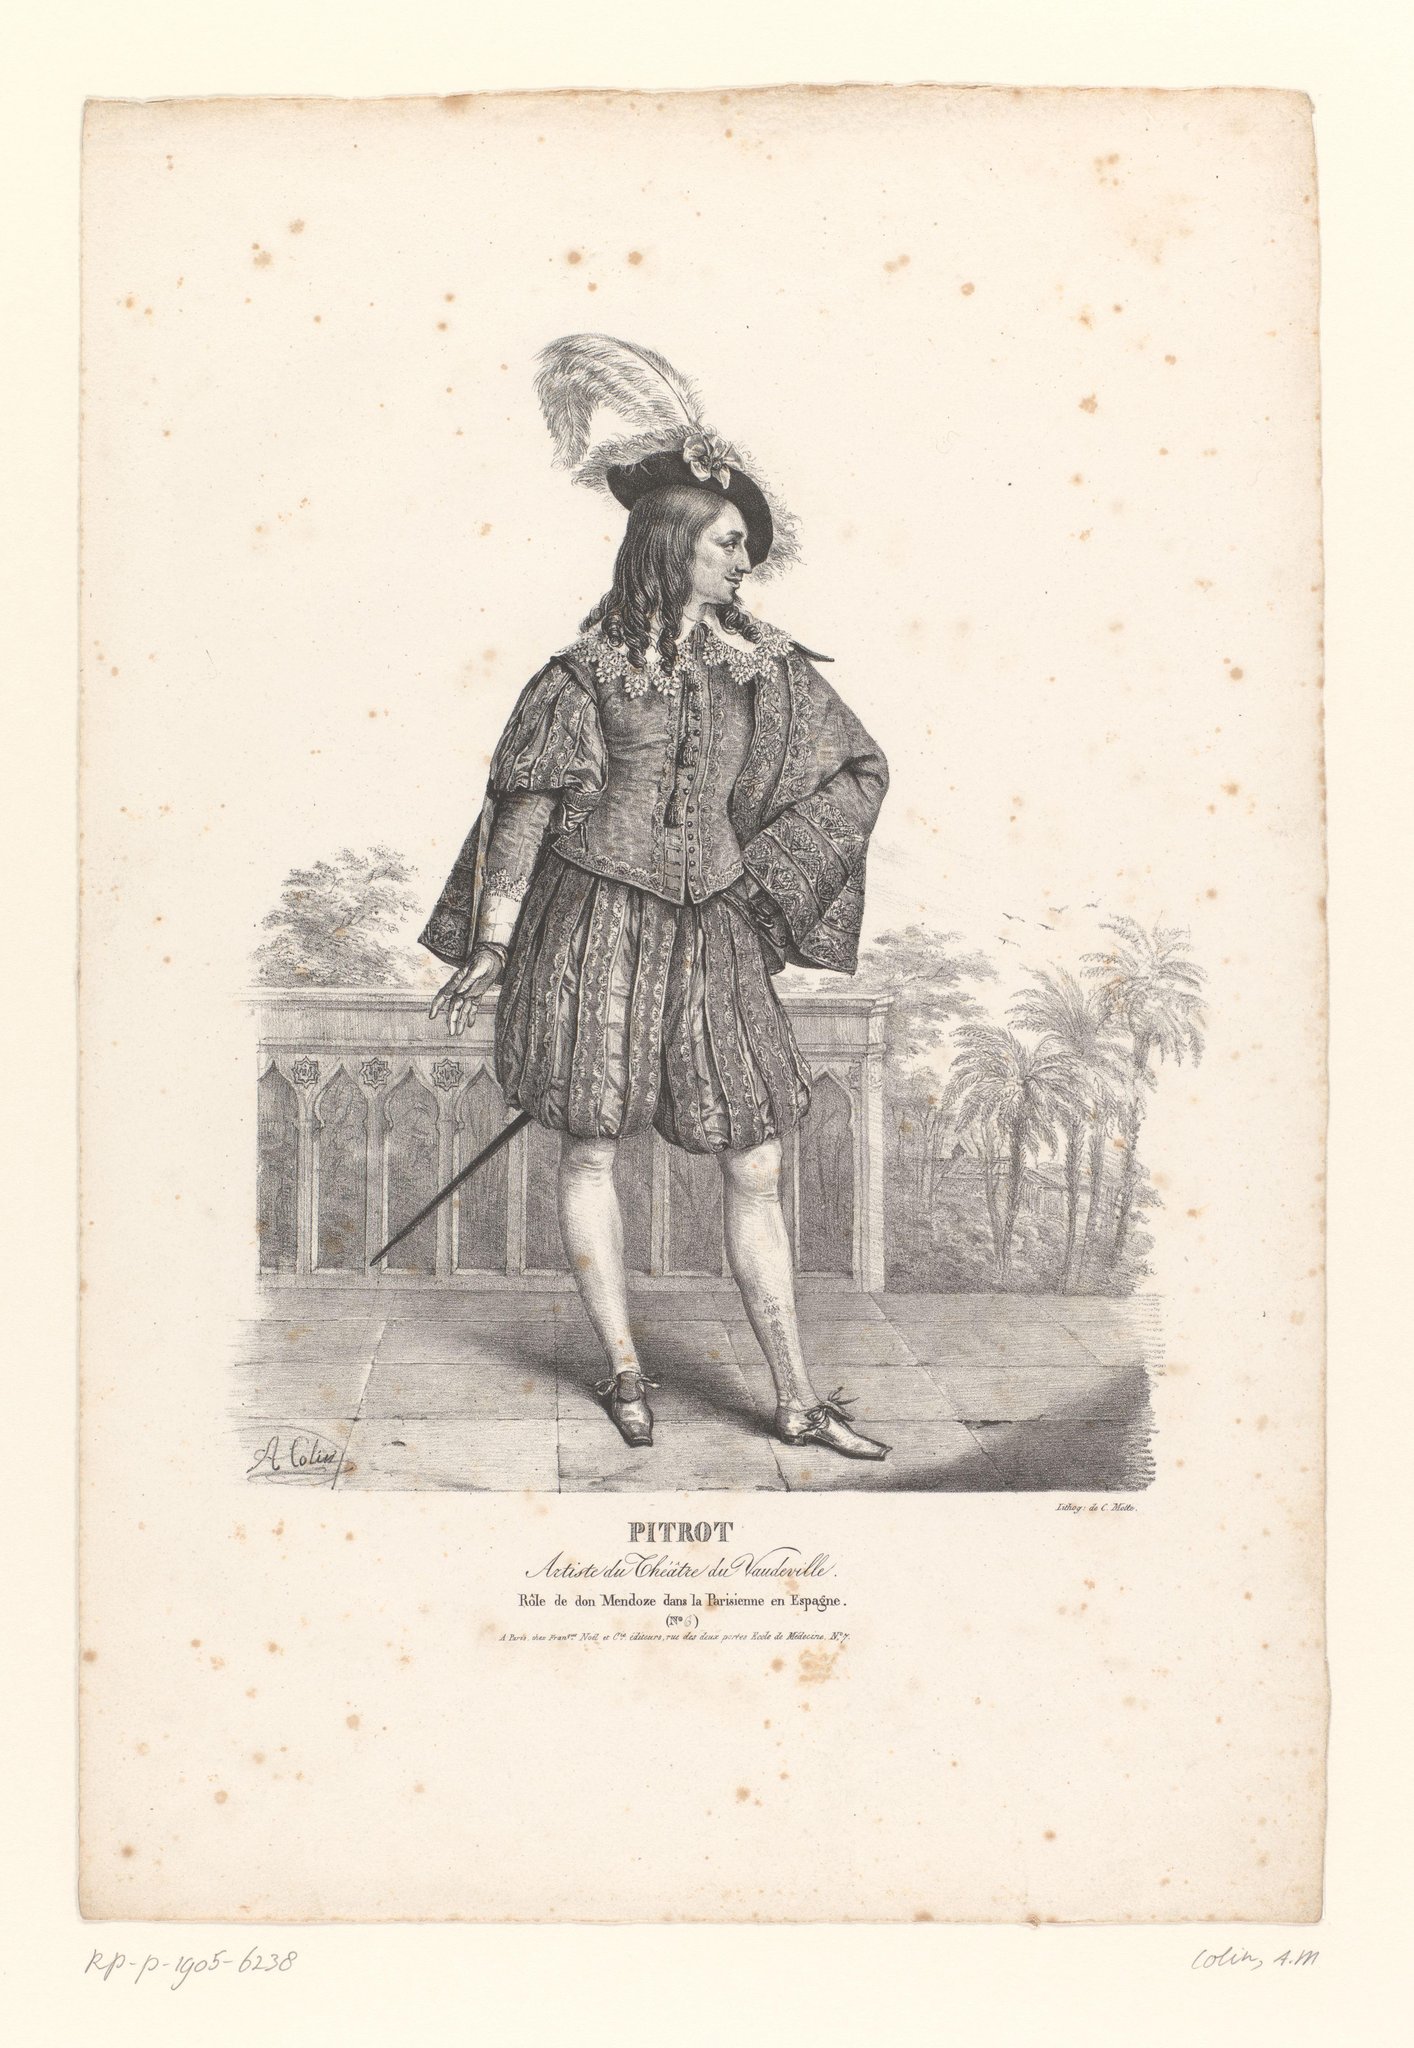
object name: print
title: Portret van Dominique Pitrot als Don Mendoze in de vaudeville La Parisienne en Espagne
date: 1823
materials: paper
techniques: lithograph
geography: paris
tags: stage costume, portrait of actor, actress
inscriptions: collector's mark: Lugt 2228a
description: Don Mendoze is een personage uit de vaudeville 'La Parisienne en Espagne', geschreven door Marc-Antoine Désaugiers en Saintine naar het gelijknamige verhaal van Jean de La Fontaine. Opgevoerd door het Théâtre du Vaudeville in Parijs in 1822.